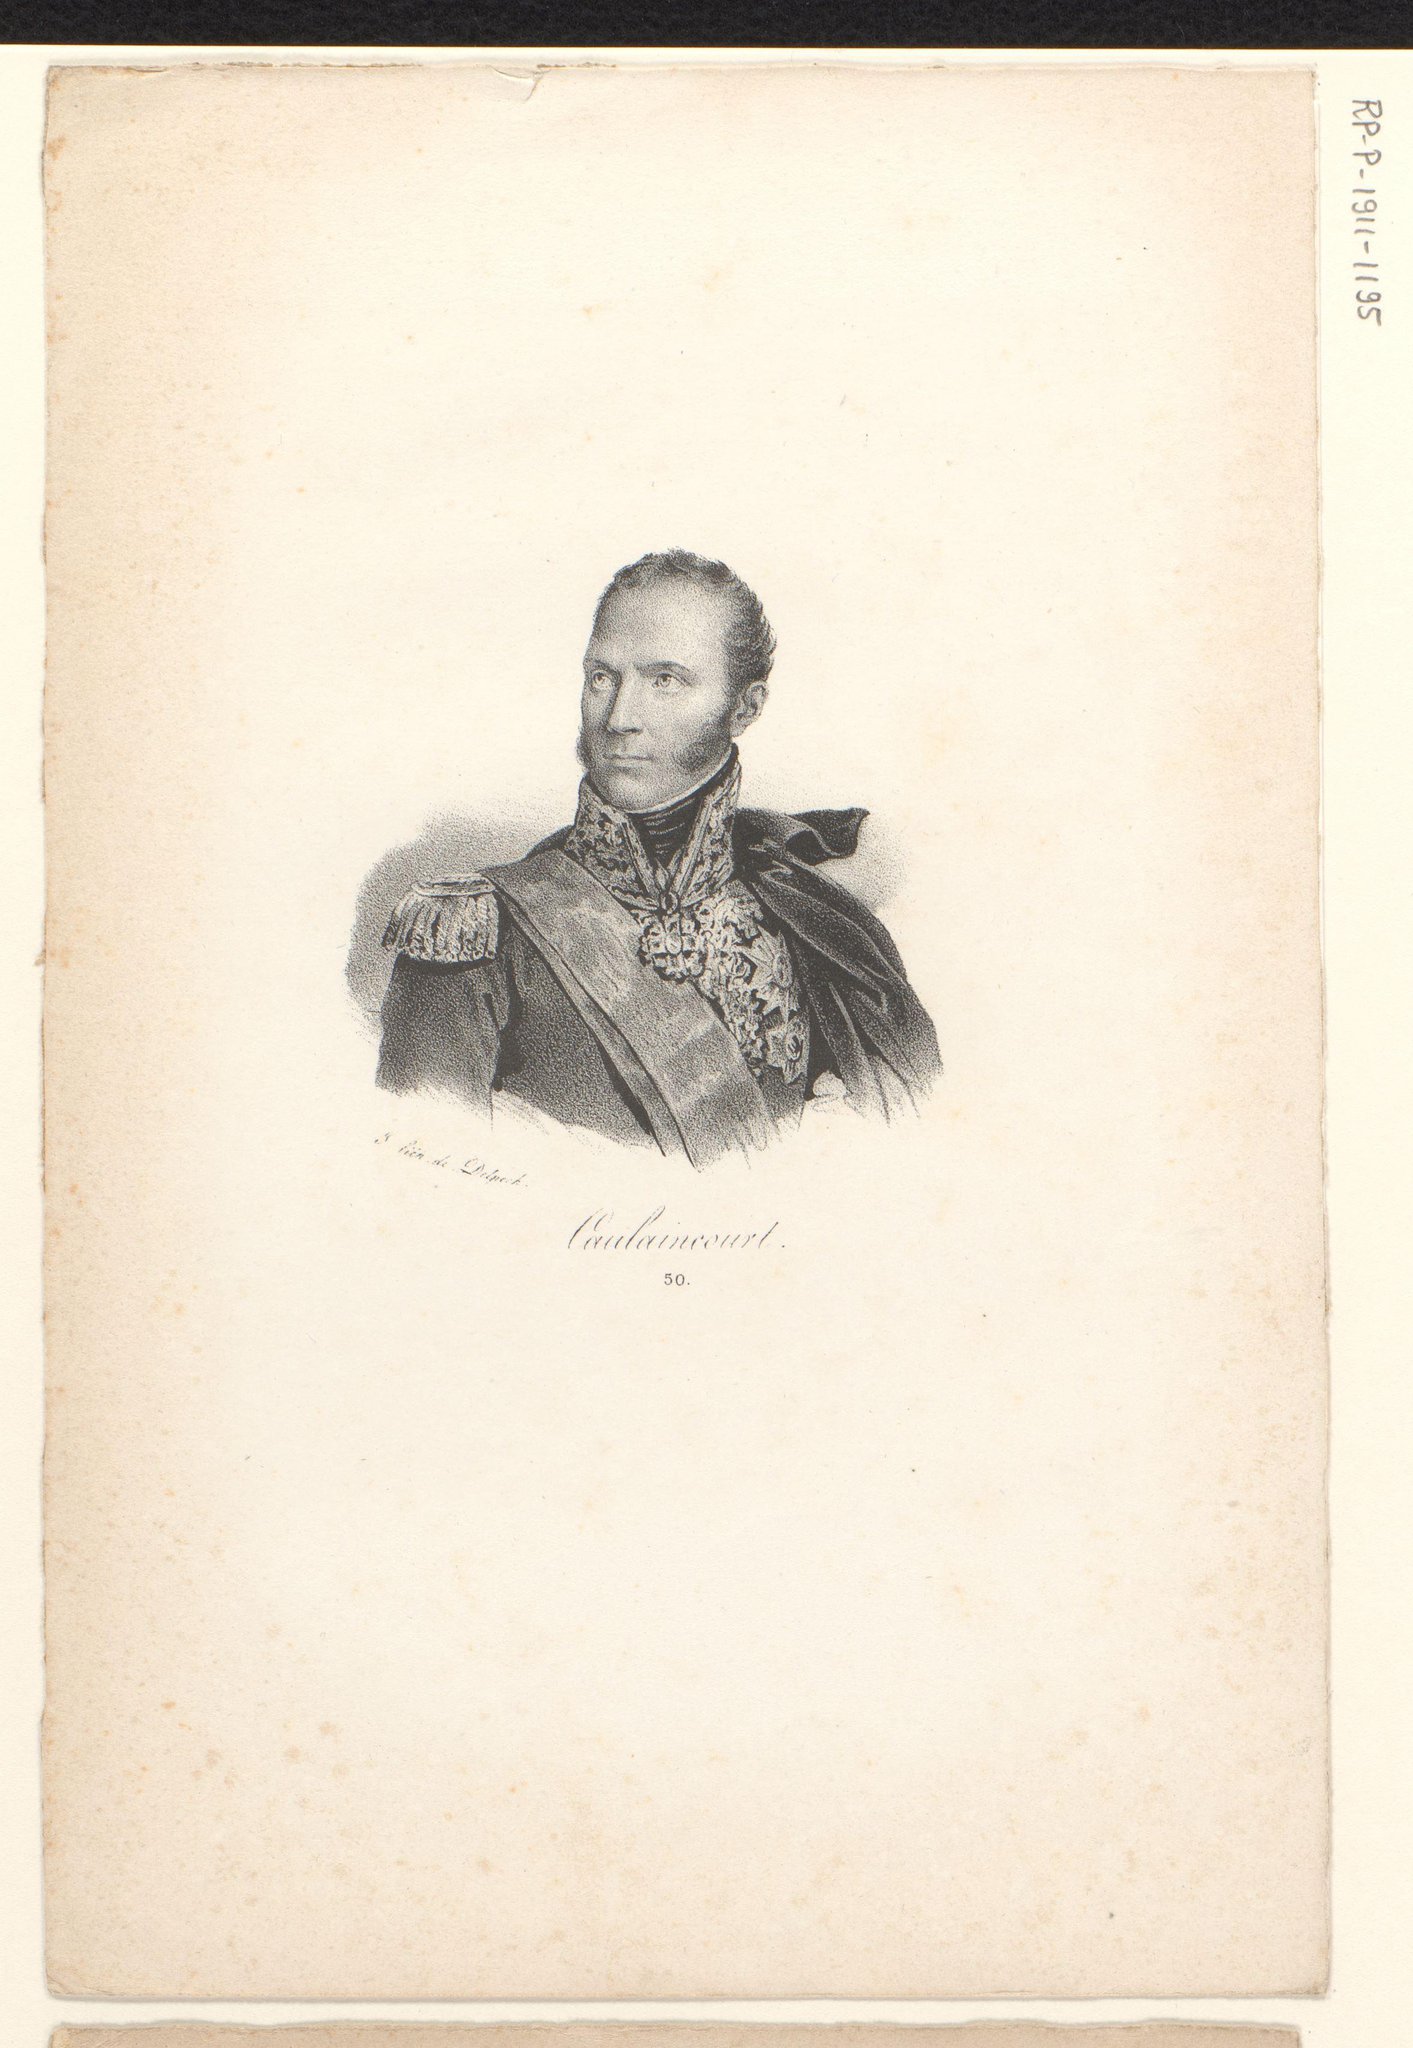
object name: print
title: Caulaincourt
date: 1818-1842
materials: paper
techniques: lithograph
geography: paris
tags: historical persons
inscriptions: collector's mark: Lugt 2228a